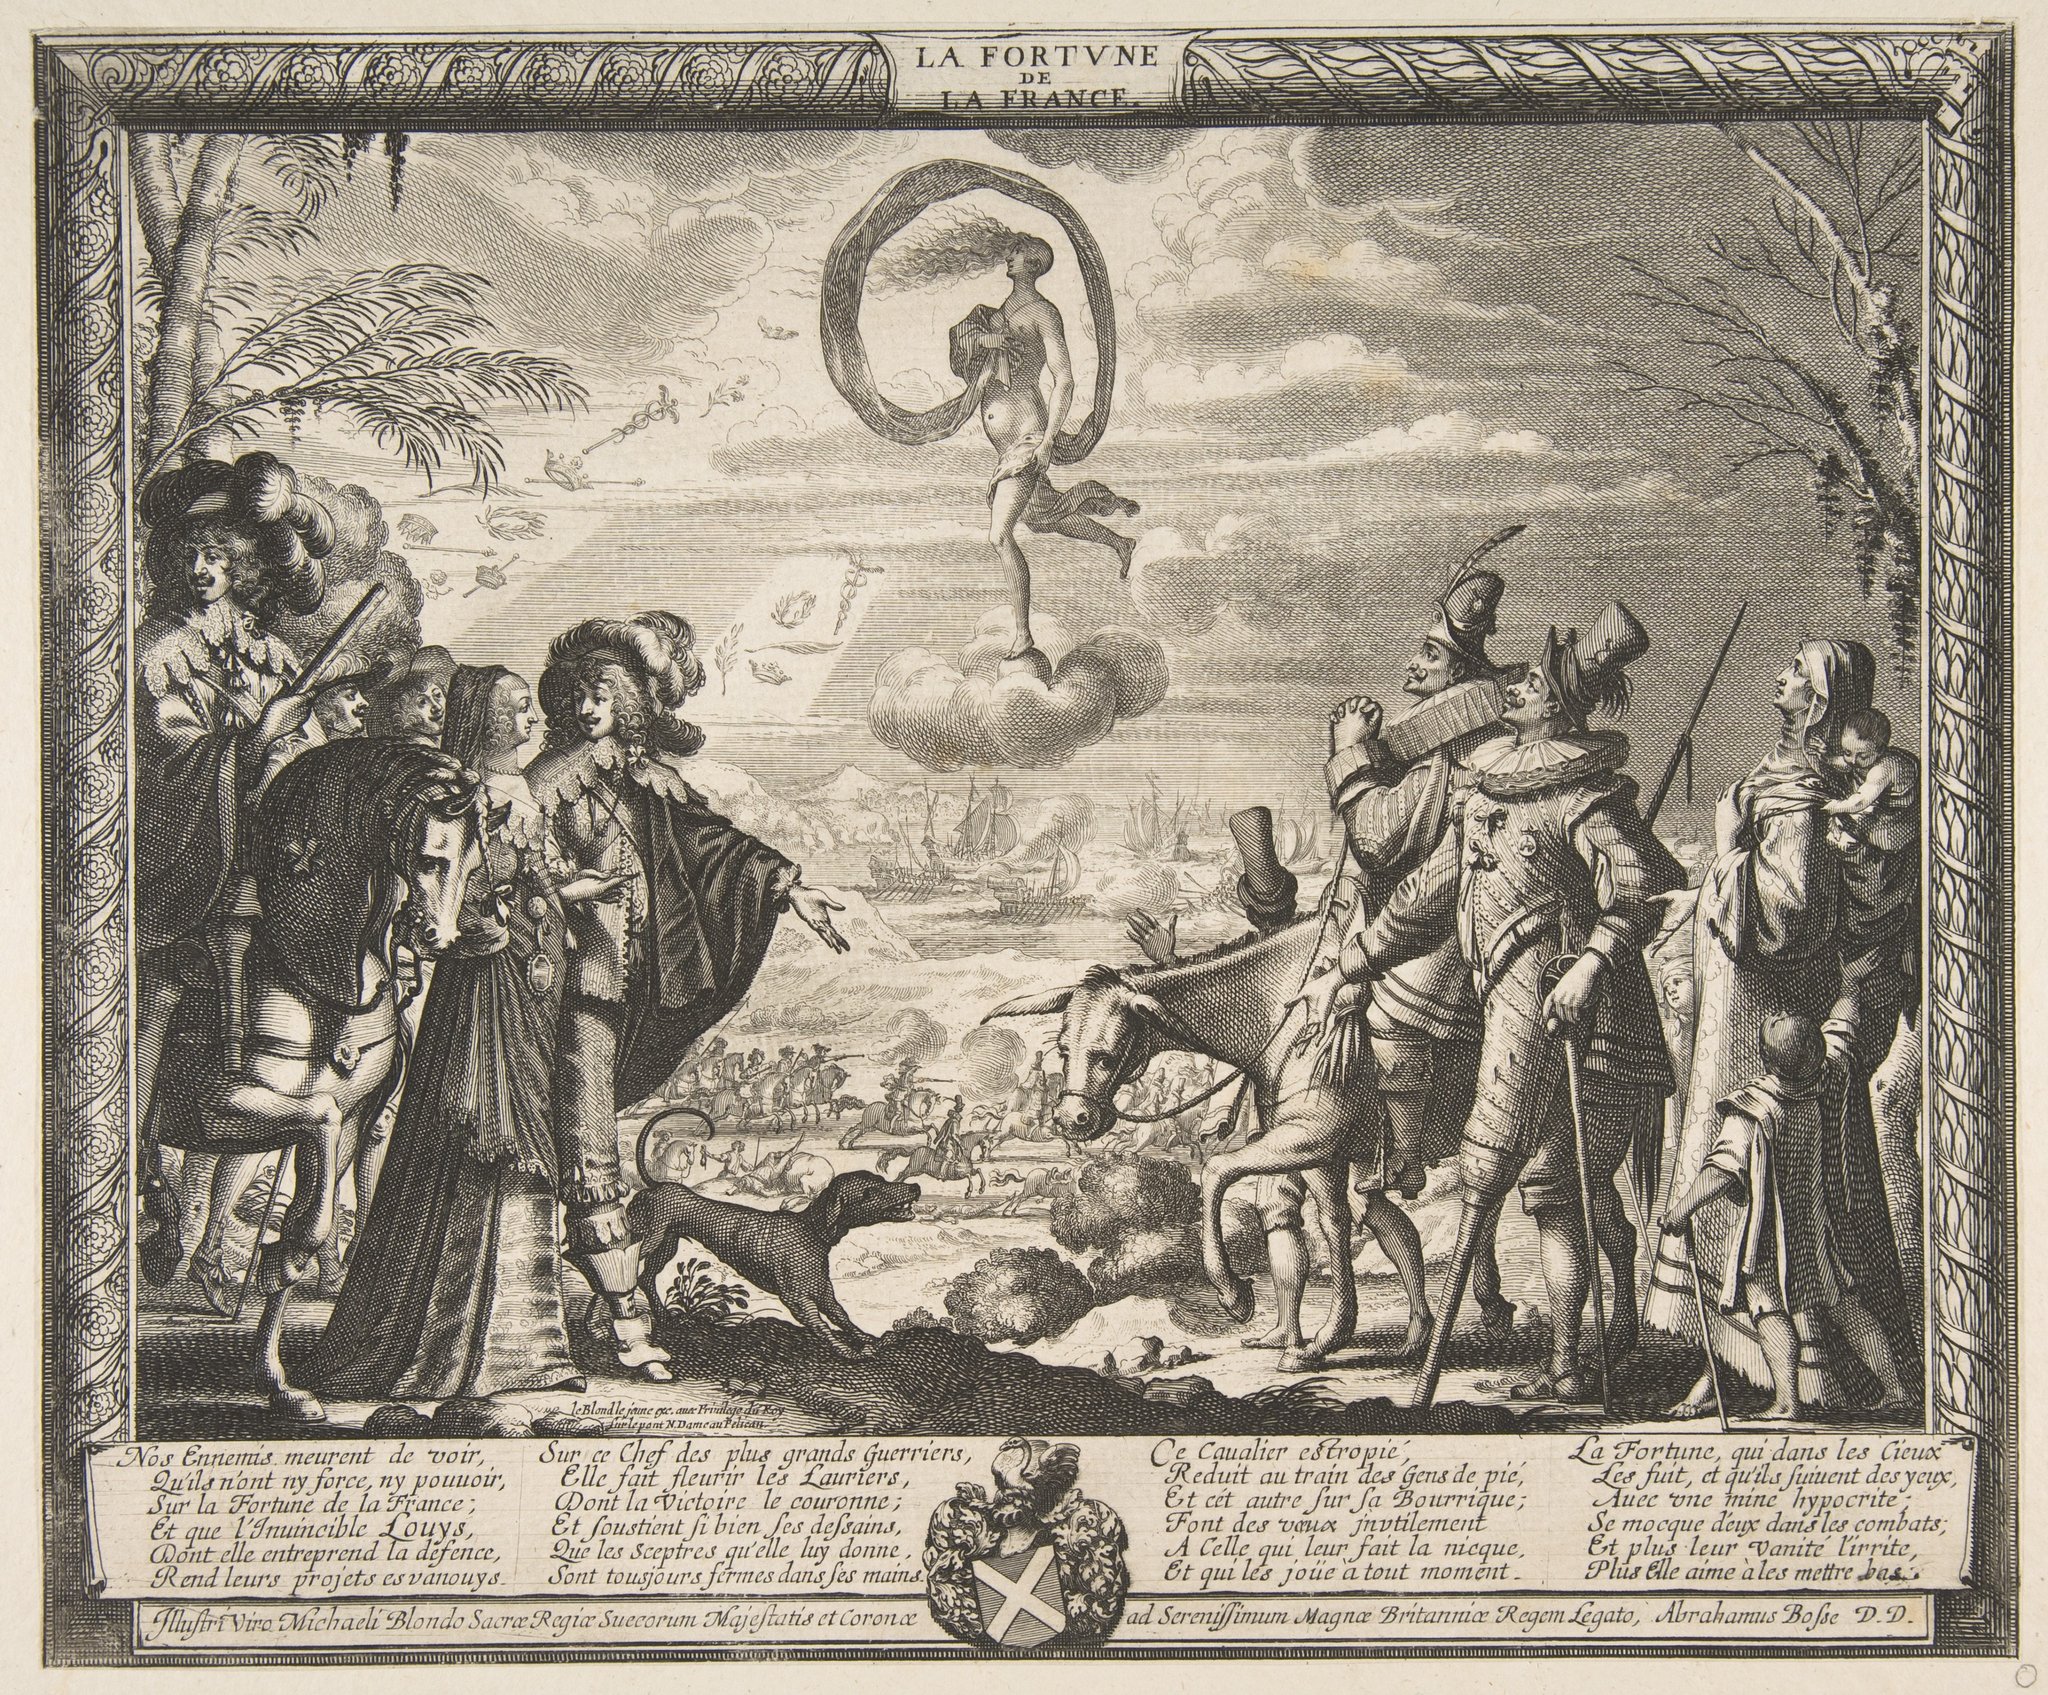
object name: print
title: Fortune Favoring France (La Fortune de la France)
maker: abraham bosse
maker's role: artist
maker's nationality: french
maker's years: 1602-1676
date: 1635-1637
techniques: etching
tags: men,women,dogs,horses